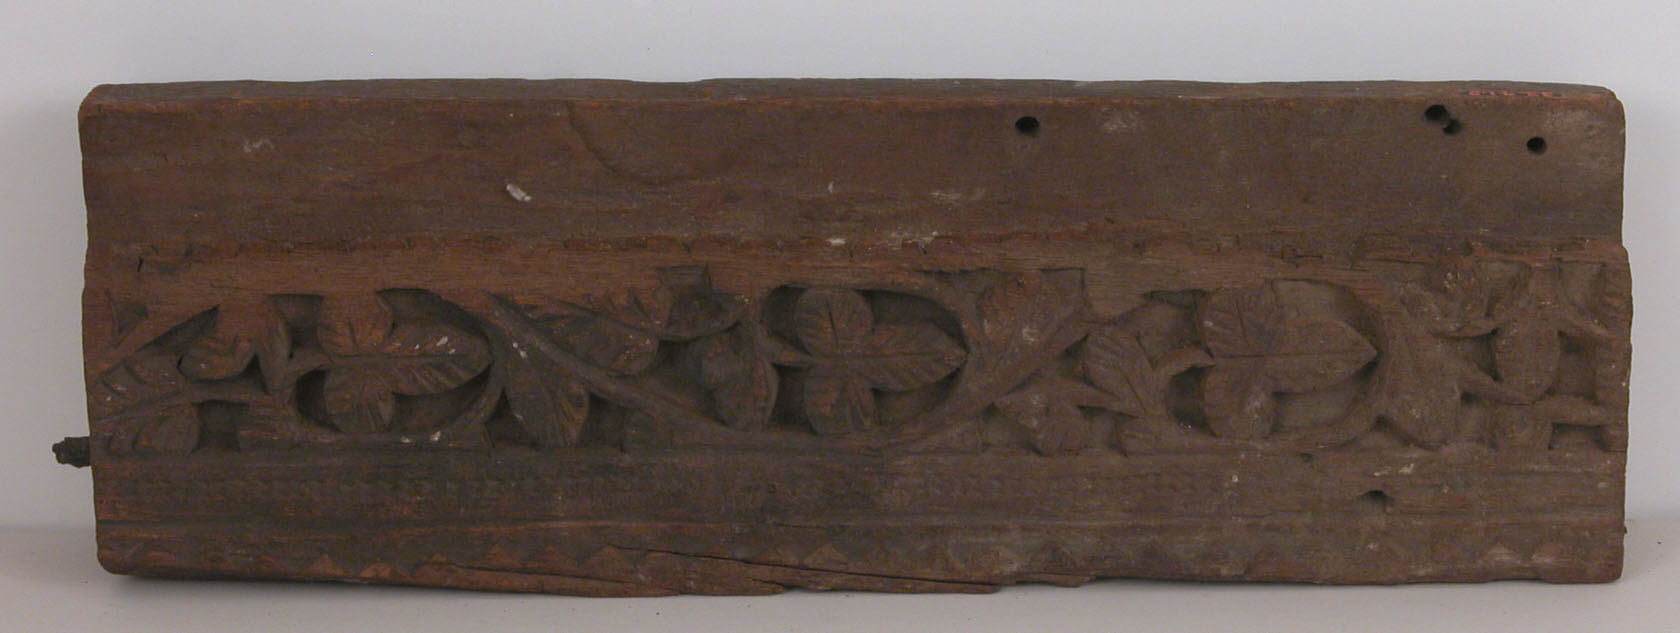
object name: panel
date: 701-900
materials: wood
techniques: carving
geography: iraq